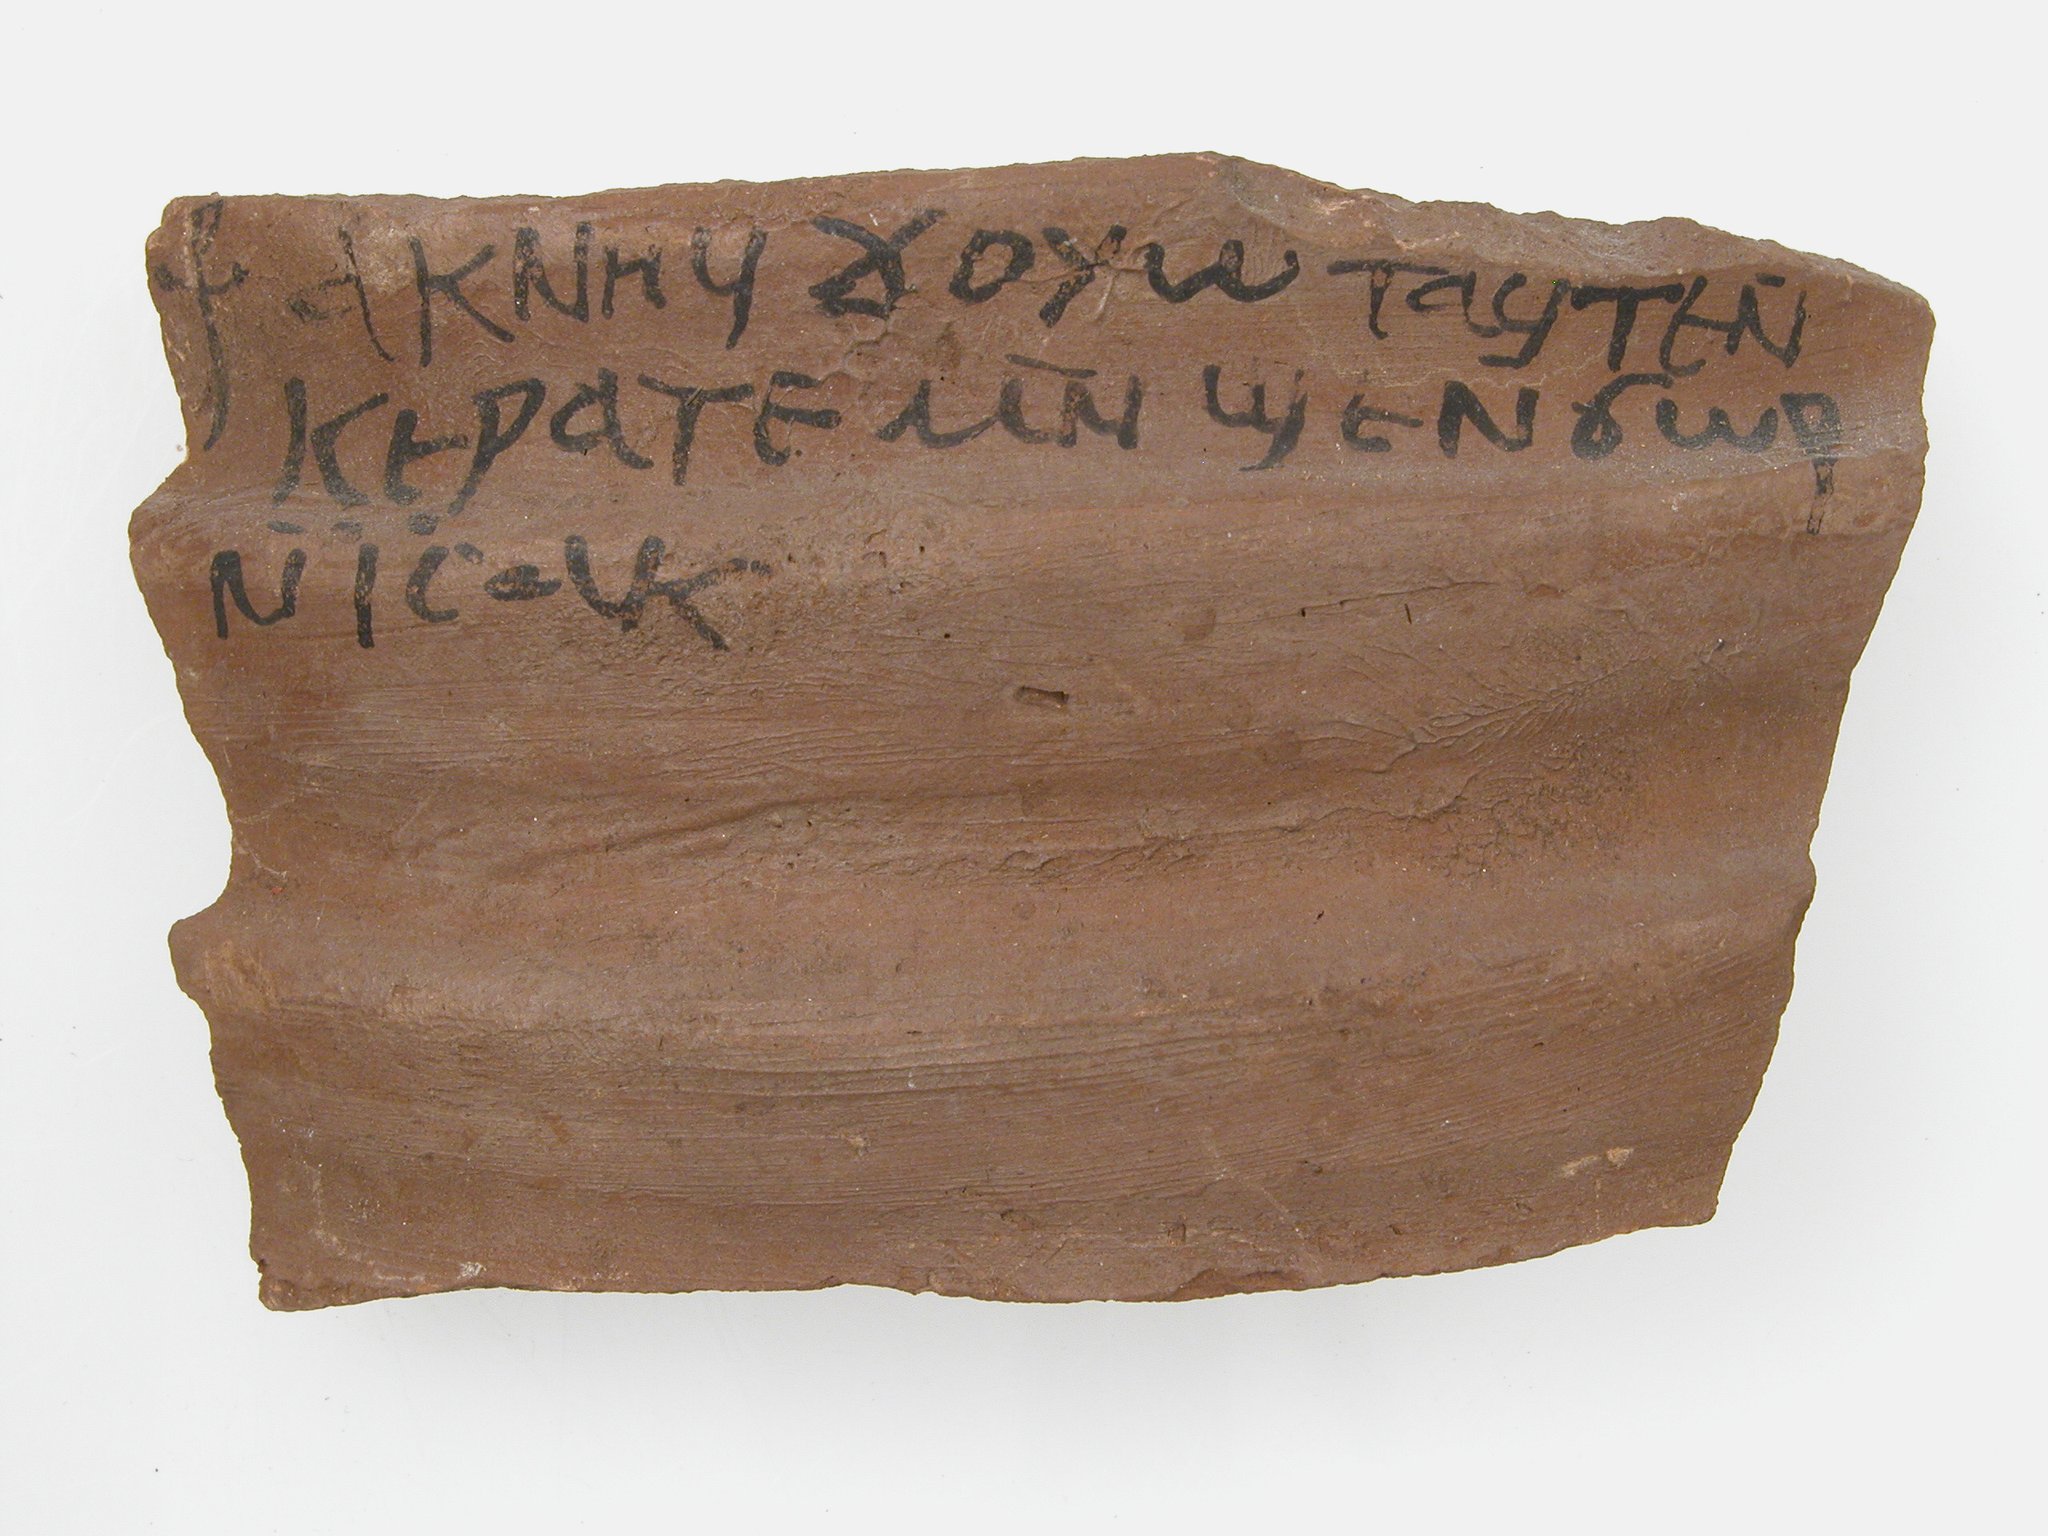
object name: ostrakon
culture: coptic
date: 601-700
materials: ink, pottery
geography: egypt